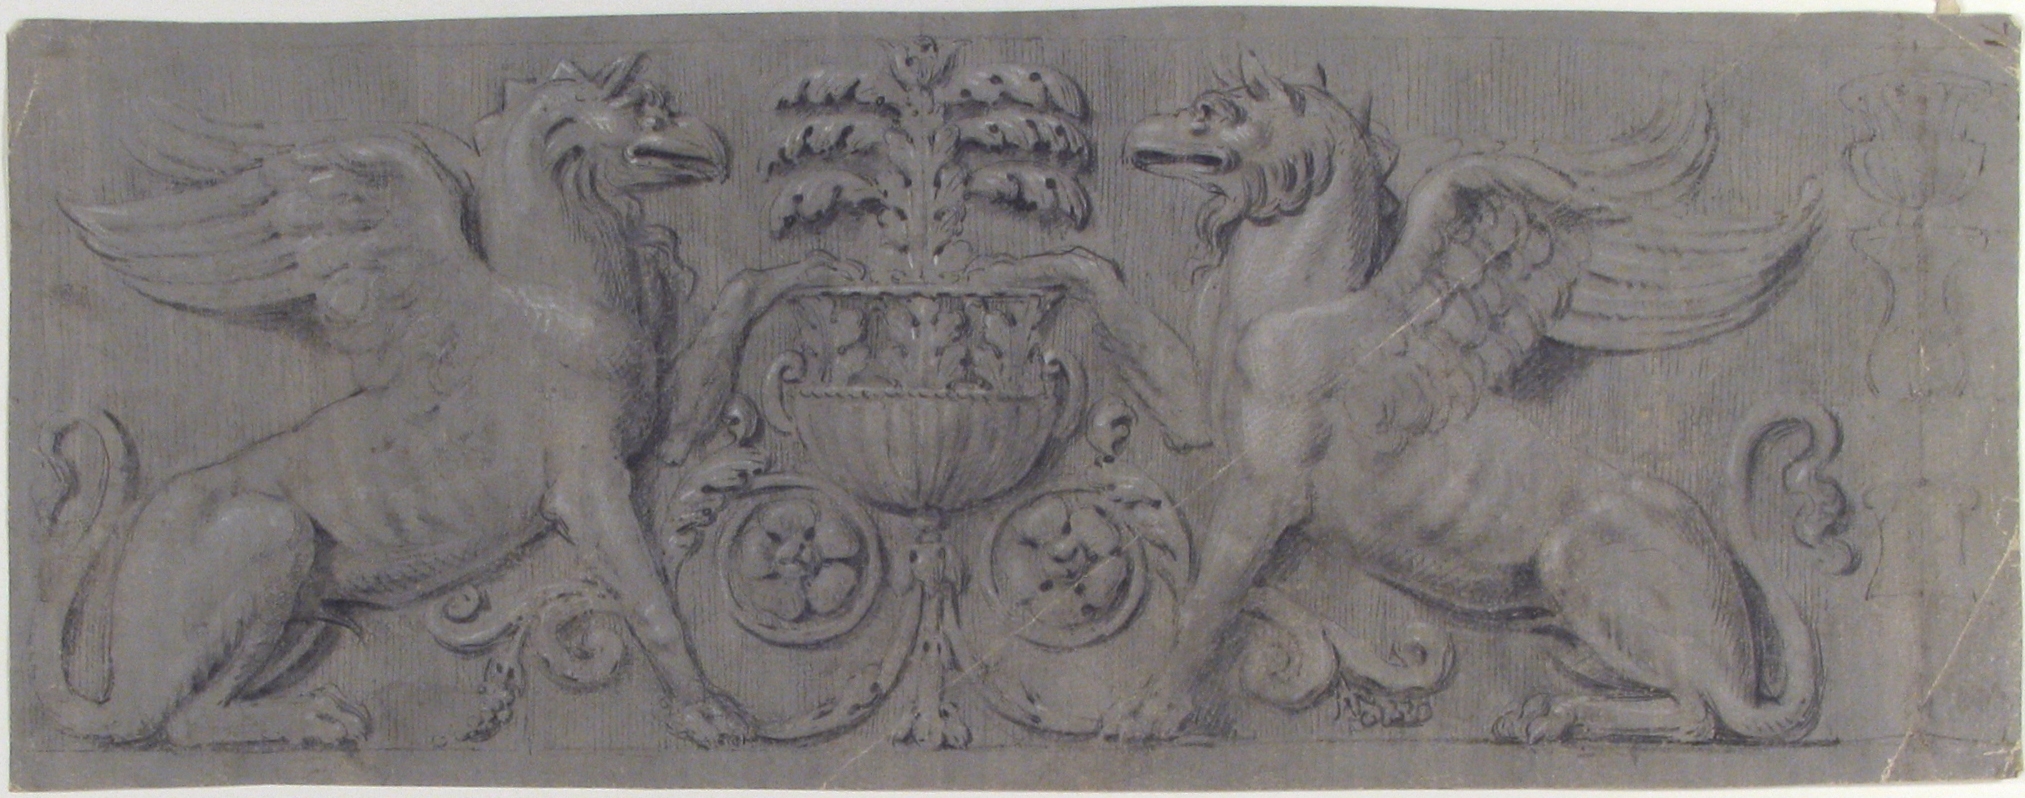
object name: drawing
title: Design for a Decorative Frieze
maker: anonymous, french, 19th century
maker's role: artist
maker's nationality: french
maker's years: 1800-1900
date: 1825-1850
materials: chalk, graphite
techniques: heightening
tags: griffins